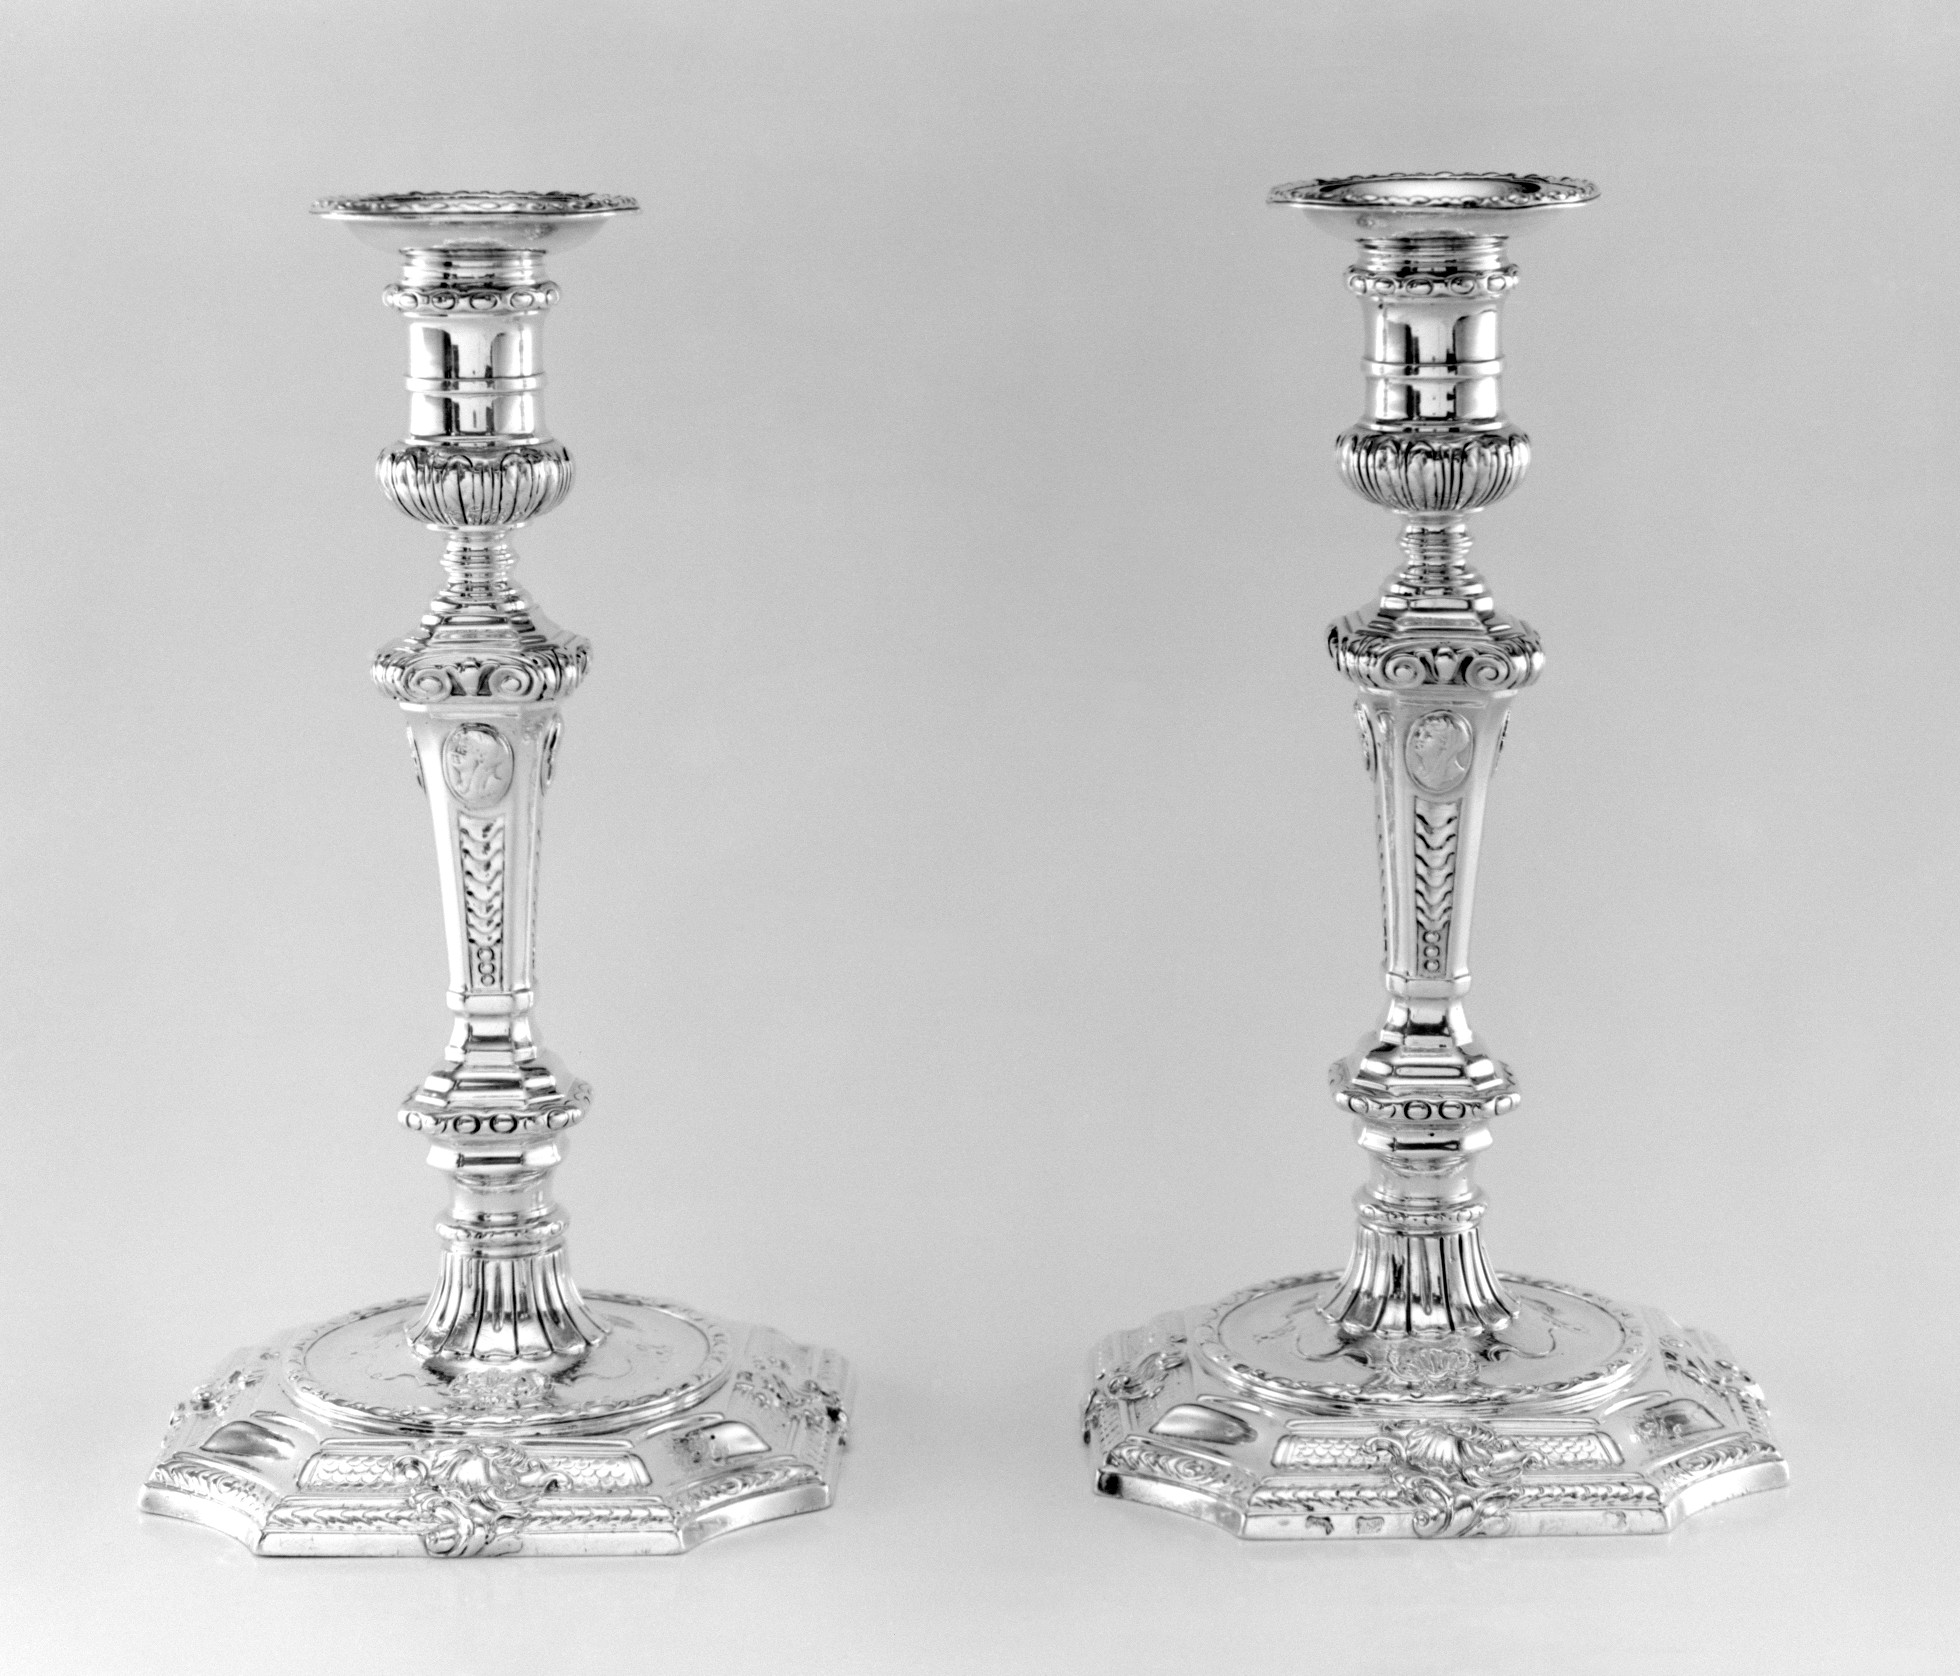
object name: candlestick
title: Set of four candlesticks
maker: paul de lamerie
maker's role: maker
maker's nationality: british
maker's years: 1688-1751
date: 1745-1746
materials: silver